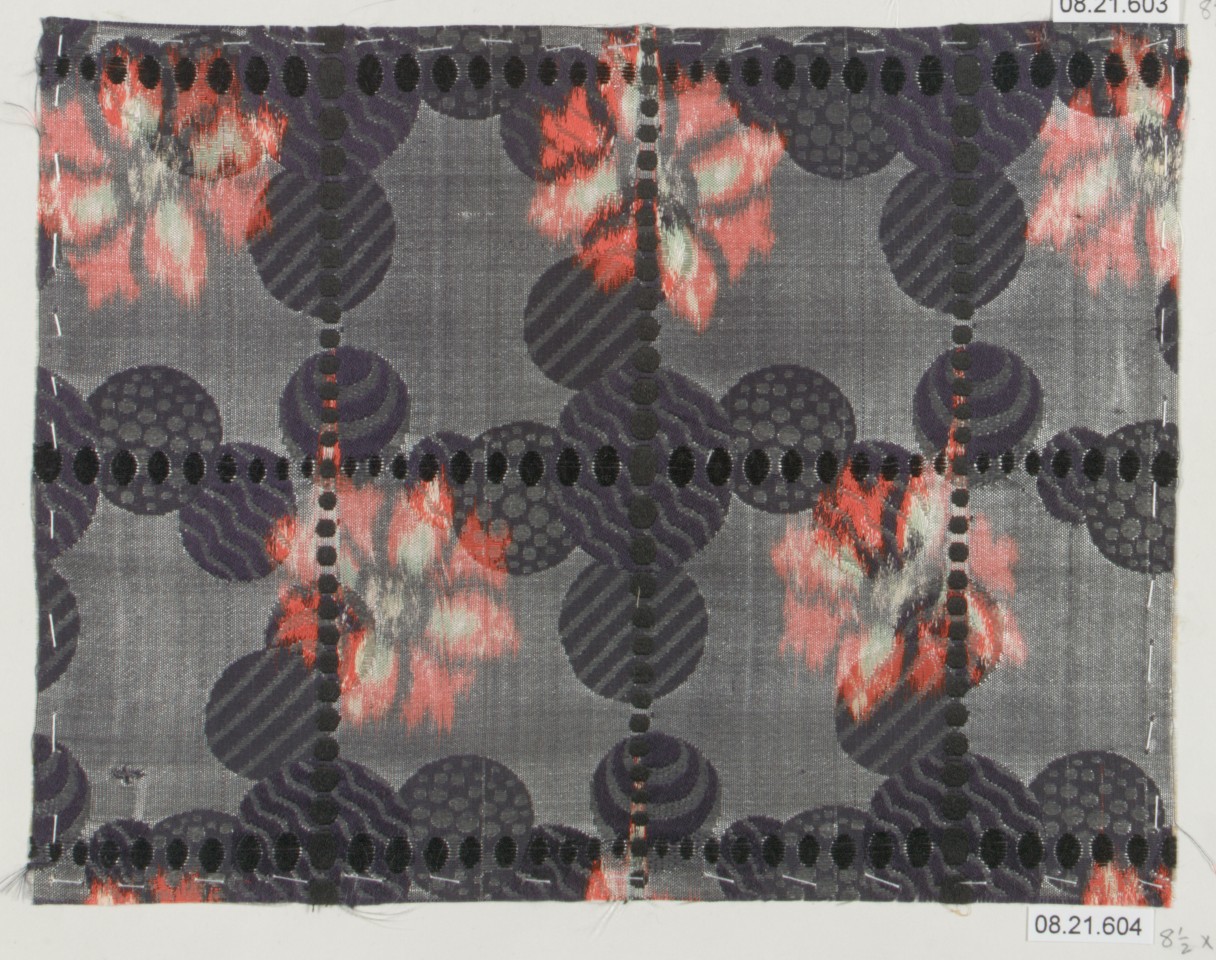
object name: textile sample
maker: Anonymous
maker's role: designer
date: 1900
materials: silk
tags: flowers